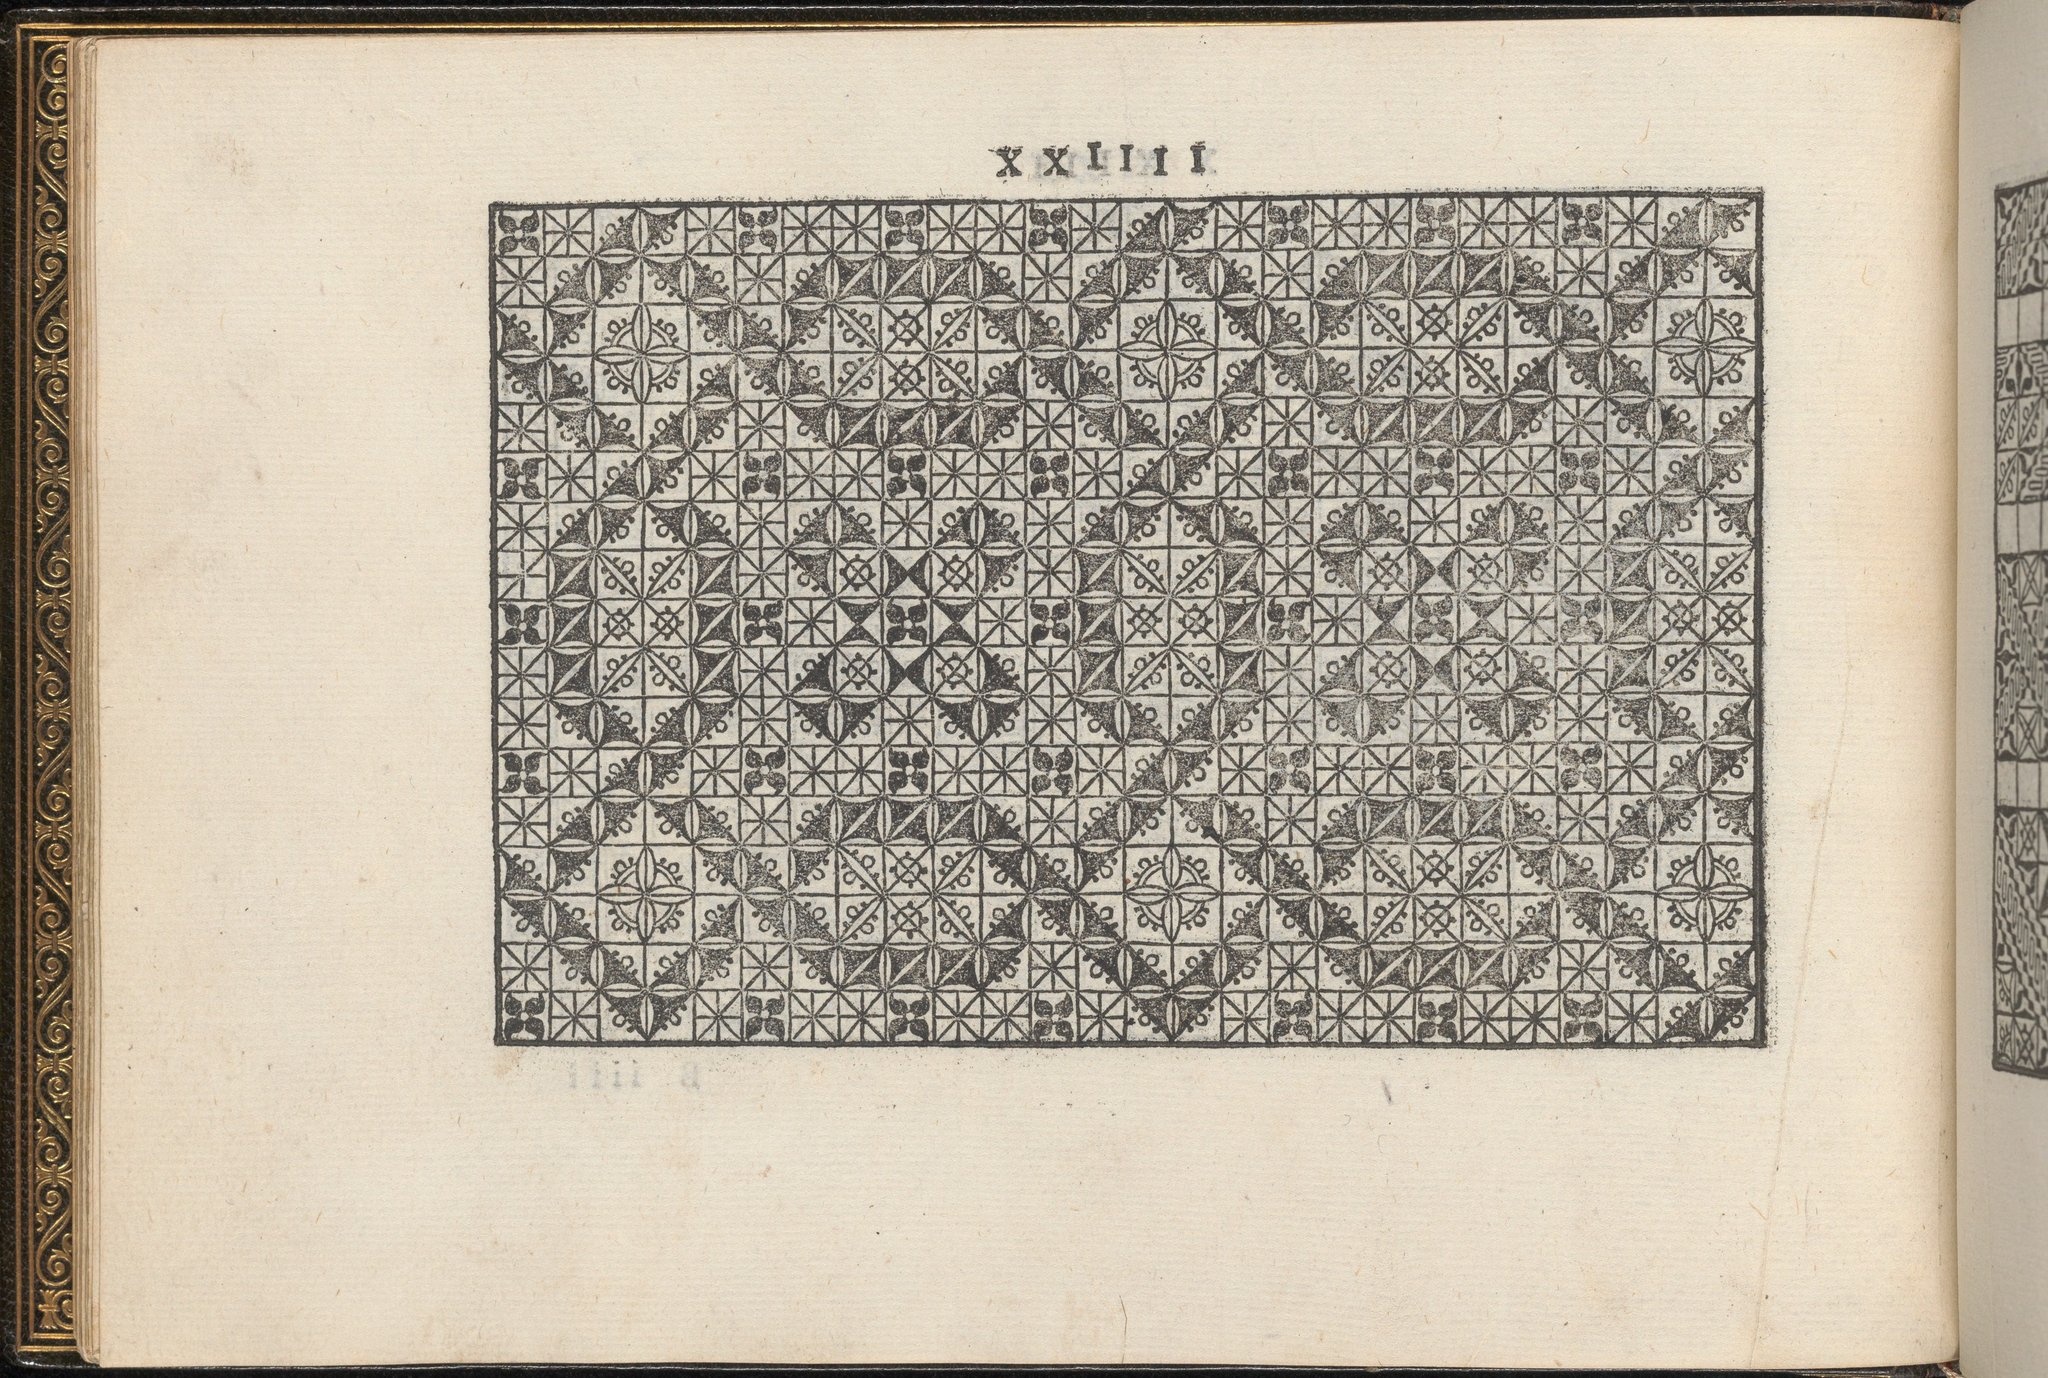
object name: book print ornament architecture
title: La Vera Perfettione del Disegno di varie sorti di recami, page 12 (verso)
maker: giovanni ostaus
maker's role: publisher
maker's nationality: italian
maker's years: 1507-1607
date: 1567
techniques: woodcut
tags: ornament